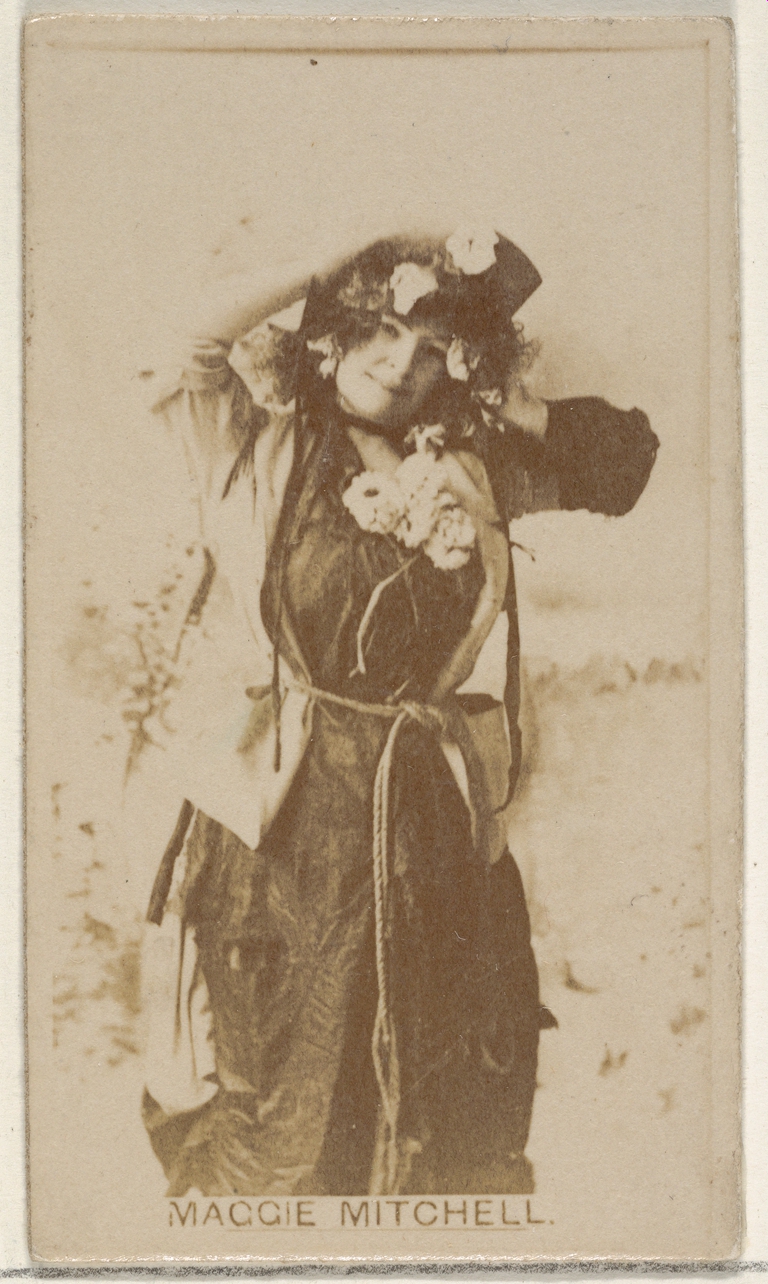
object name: photograph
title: Maggie Mitchell, from the Actors and Actresses series (N45, Type 8) for Virginia Brights Cigarettes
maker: allen & ginter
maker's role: publisher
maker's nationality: american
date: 1888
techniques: albumen silver print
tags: portraits,women,actresses